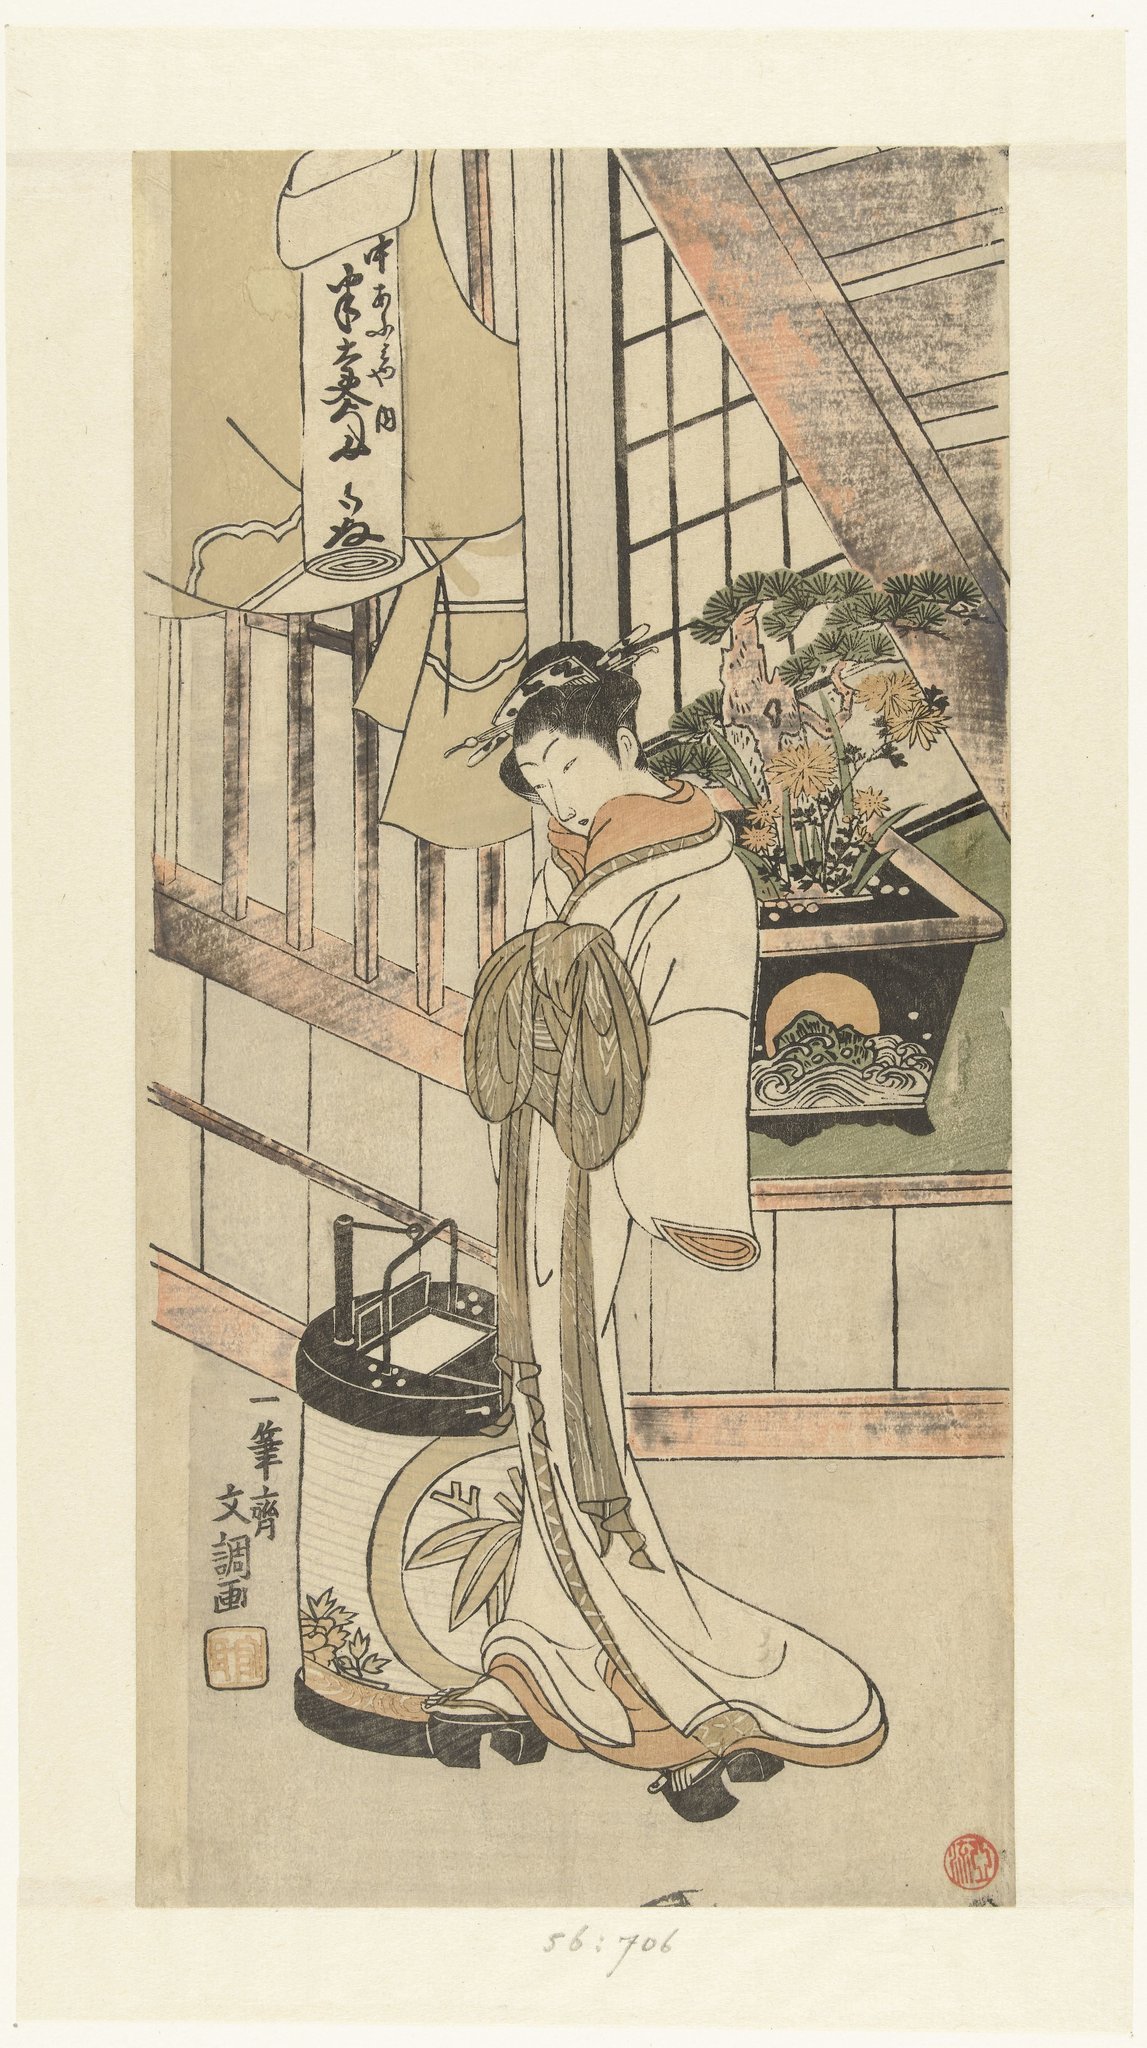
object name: print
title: Courtisane Handayu uit het Naka-omi huis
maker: ippitsusai bunchô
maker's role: print maker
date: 1768-1772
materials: paper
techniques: woodcut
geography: japan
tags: courtesan, hetaera, plants; vegetation (+ flowers, blossom, blossoming), lantern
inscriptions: collector's mark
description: Courtisane in witte kimono, staand naast grote witte lantaarn; op de achtergrond een huis en een groot bloemstuk met pijnboomtak onder een ladder. De titel van de prent staat in het witte cartouche in de vorm van een liefdesbrief, linksboven.